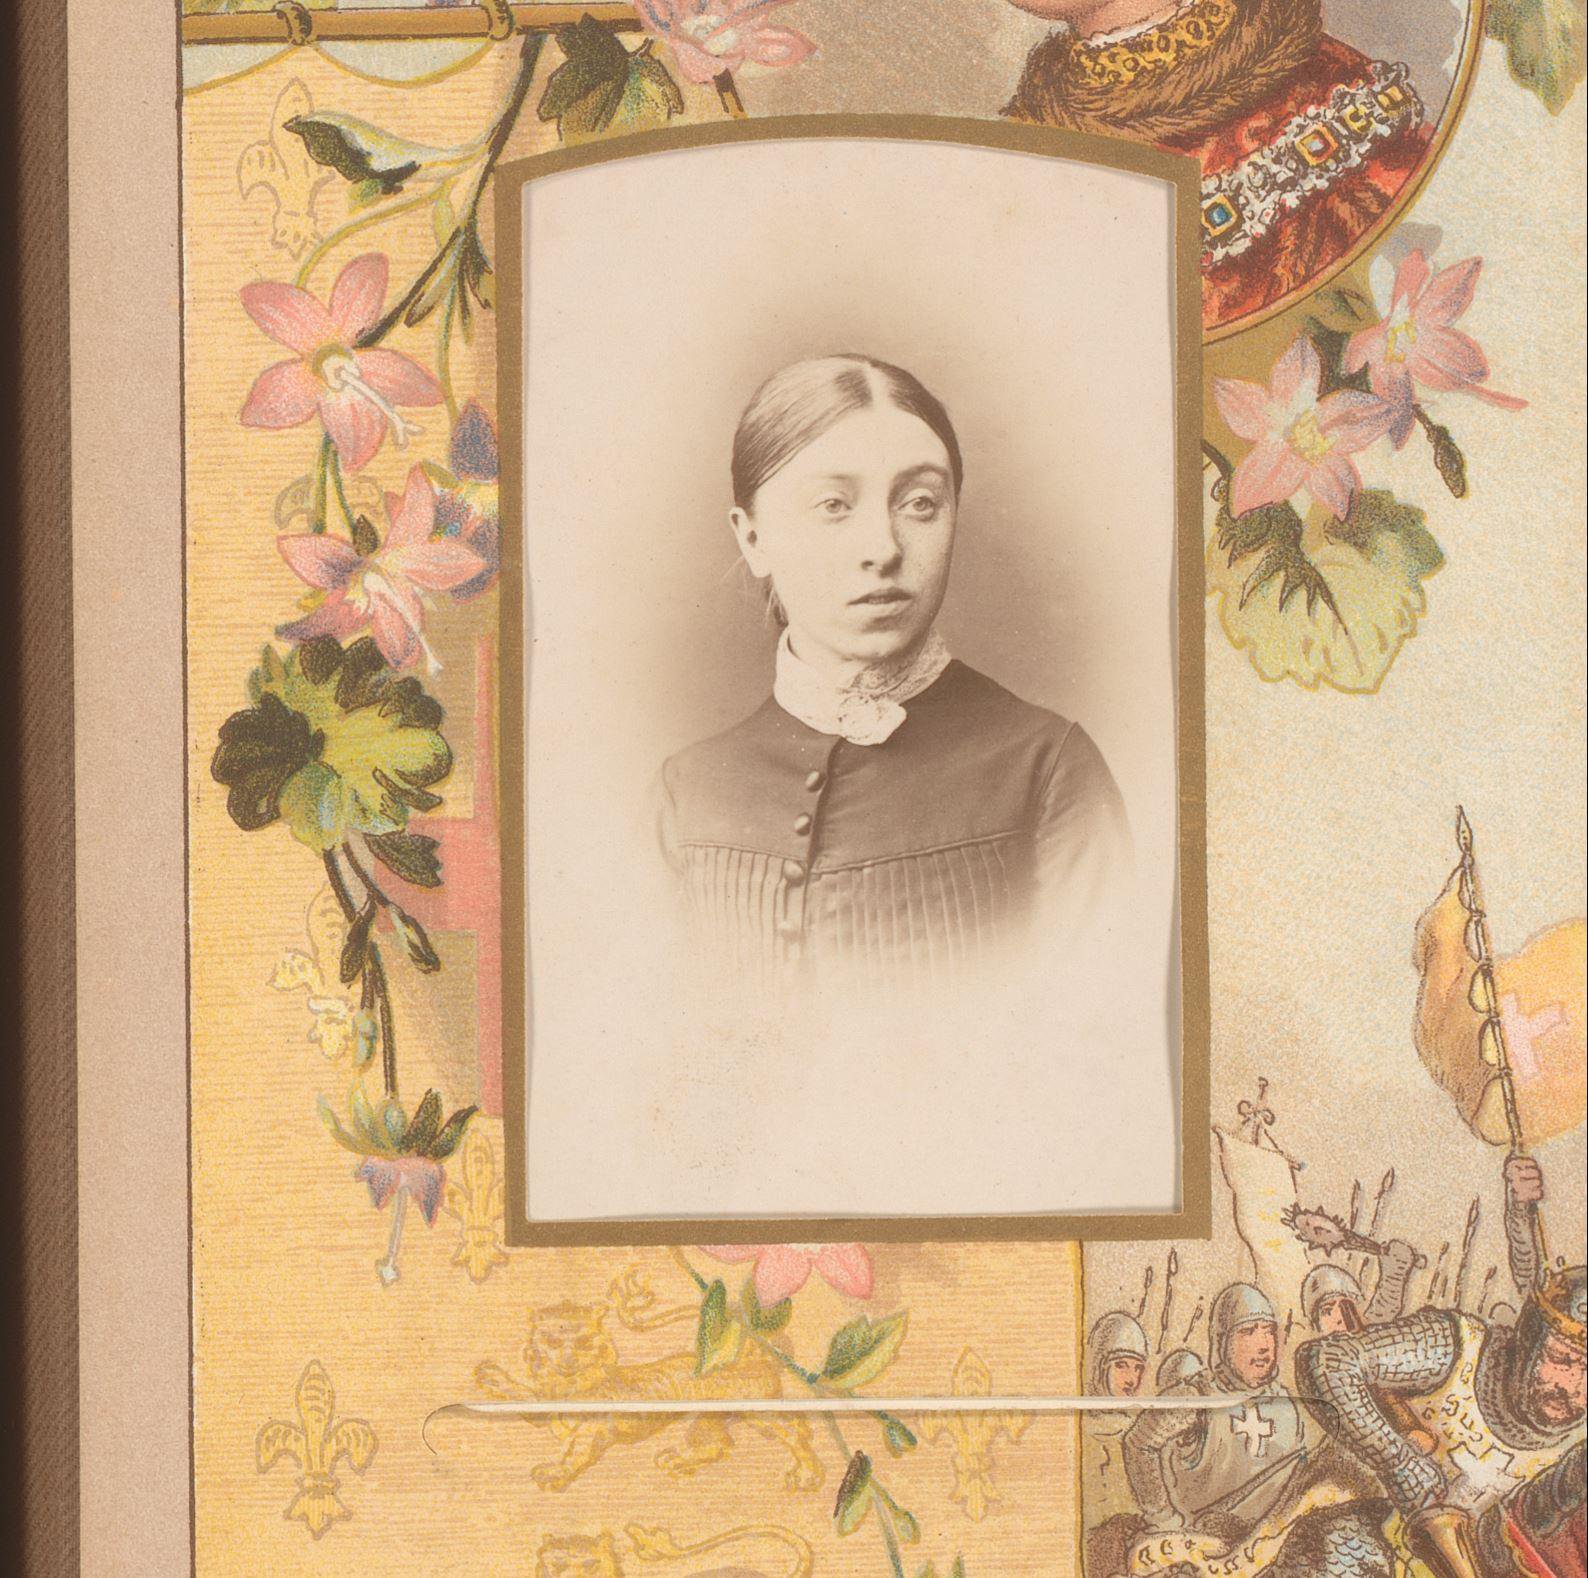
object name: album leaf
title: Portret van een jonge vrouw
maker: henry oshea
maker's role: fotograaf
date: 1882-1900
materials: cardboard, photographic support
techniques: albumen print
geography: limerick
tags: adolescent, young woman, maiden, historical persons - bb - woman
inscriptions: inscription: ‘Photographer/ Miniature/ and/ Portrait Painter/ Henry O'Shea/ 127, George Street/ Limerick./ NEGATIVES KEPT/ COPIES MAY BE HAD’